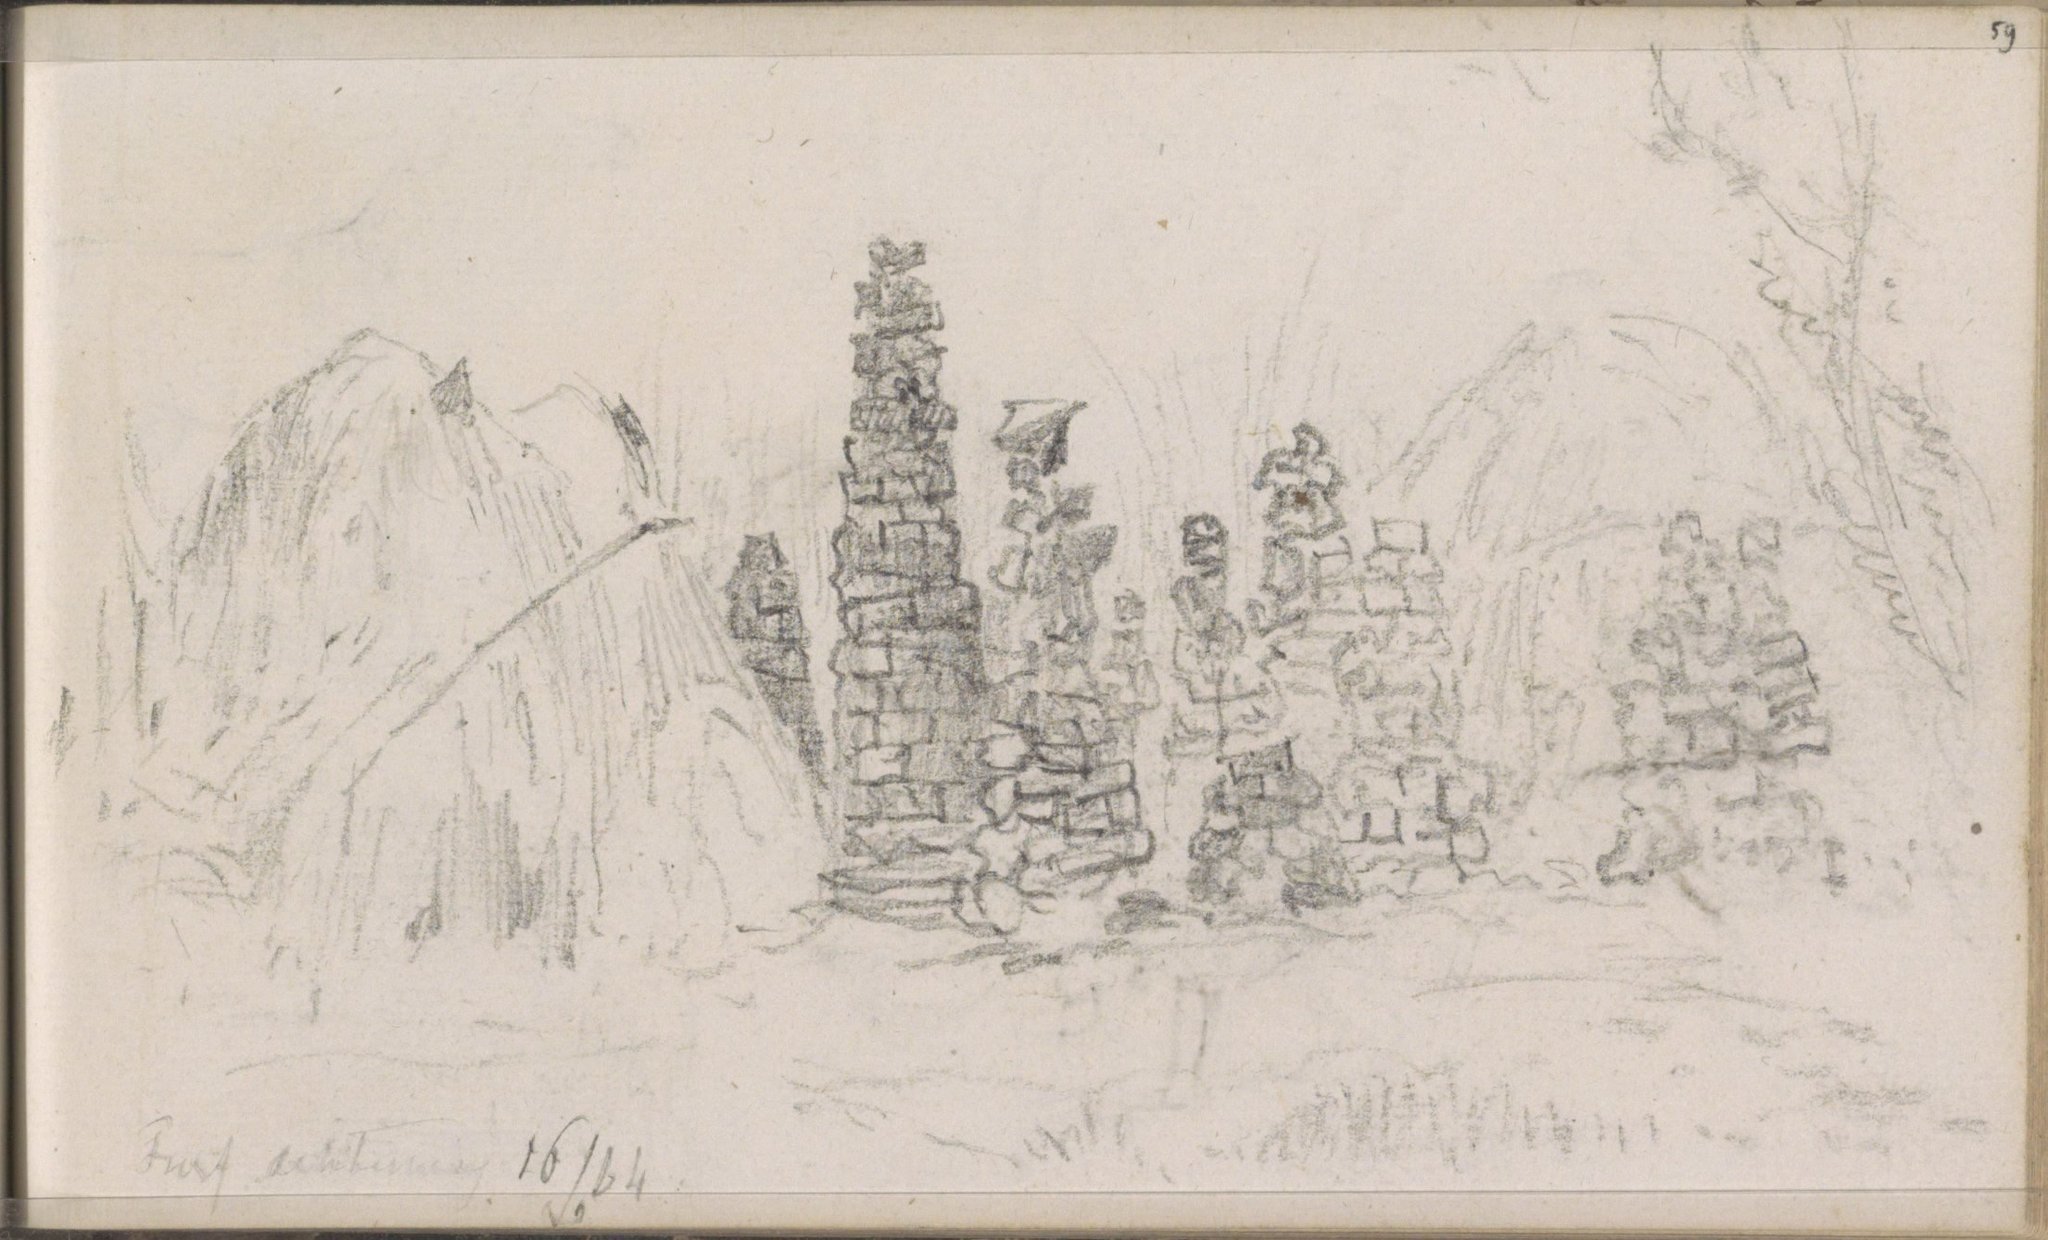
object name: sketchbook leaf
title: Stapels turf en hooibalen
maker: johannes tavenraat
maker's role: draughtsman, painter, print maker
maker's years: 1809-1881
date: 1809-1864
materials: paper, pencil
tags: peat (soil type), hay-stack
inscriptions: date and inscription: ‘turf [...] 16/64’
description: Blad 59 recto uit een schetsboek met 98 bladen.